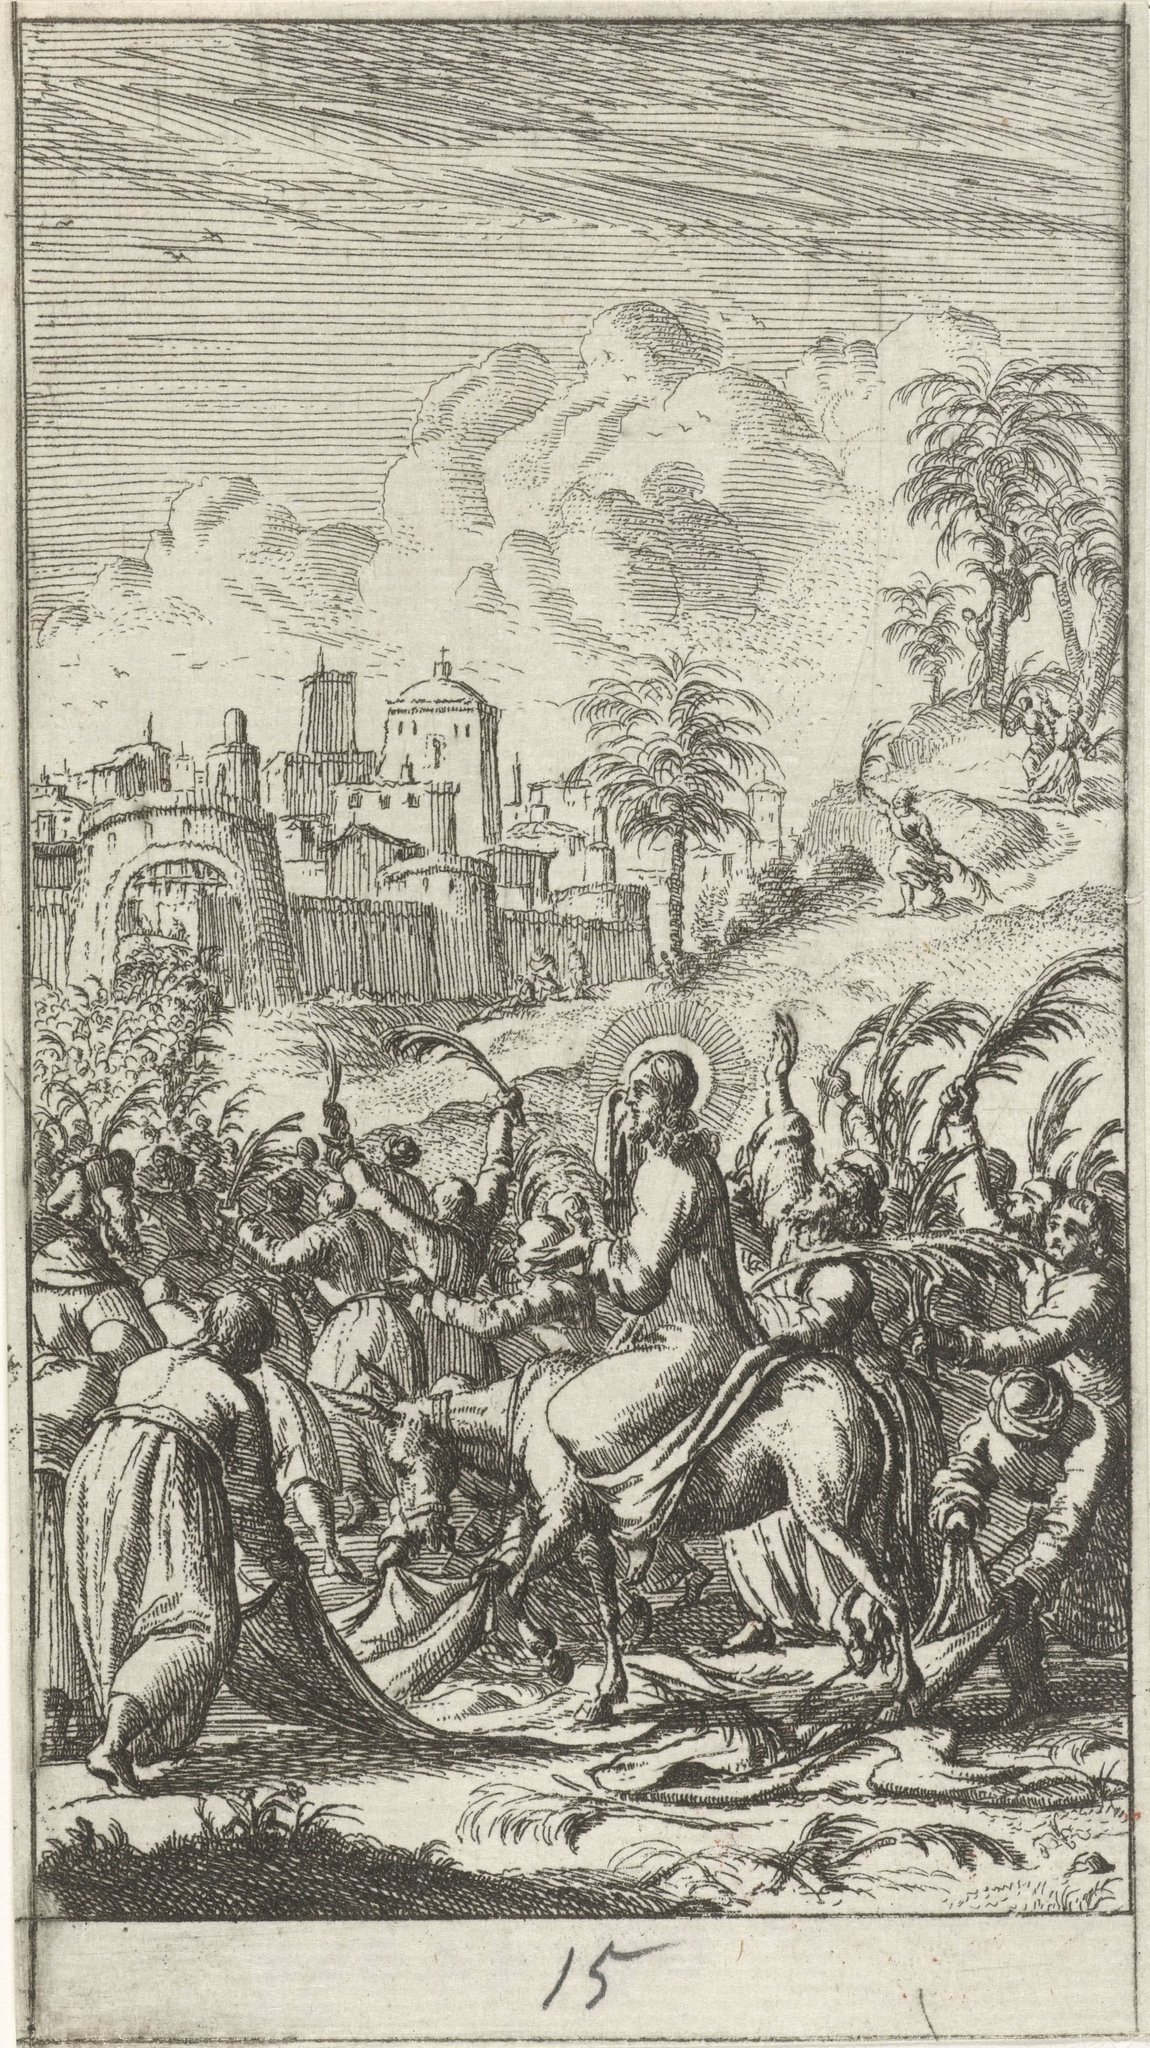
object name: print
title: Christus voorspelt de vernietiging van Jeruzalem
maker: Anonymous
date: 1681-1762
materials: paper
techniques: etching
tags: christ mourning over jerusalem and its future destruction (luke 19:41-44)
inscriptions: number: ‘15’, collector's mark: Lugt 240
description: Kopie naar prent van J. Luyken, mogelijk voor het eerst verschenen in: Het Nieuwe Testament ofte alle Boecken des Nieuwen Verbondts onses Heeren Iesu Christi. Amsterdam: Hieronymus Sweerts, Jan ten Hoorn, Jan Bouman en Daniel van den Dalen, 1681.